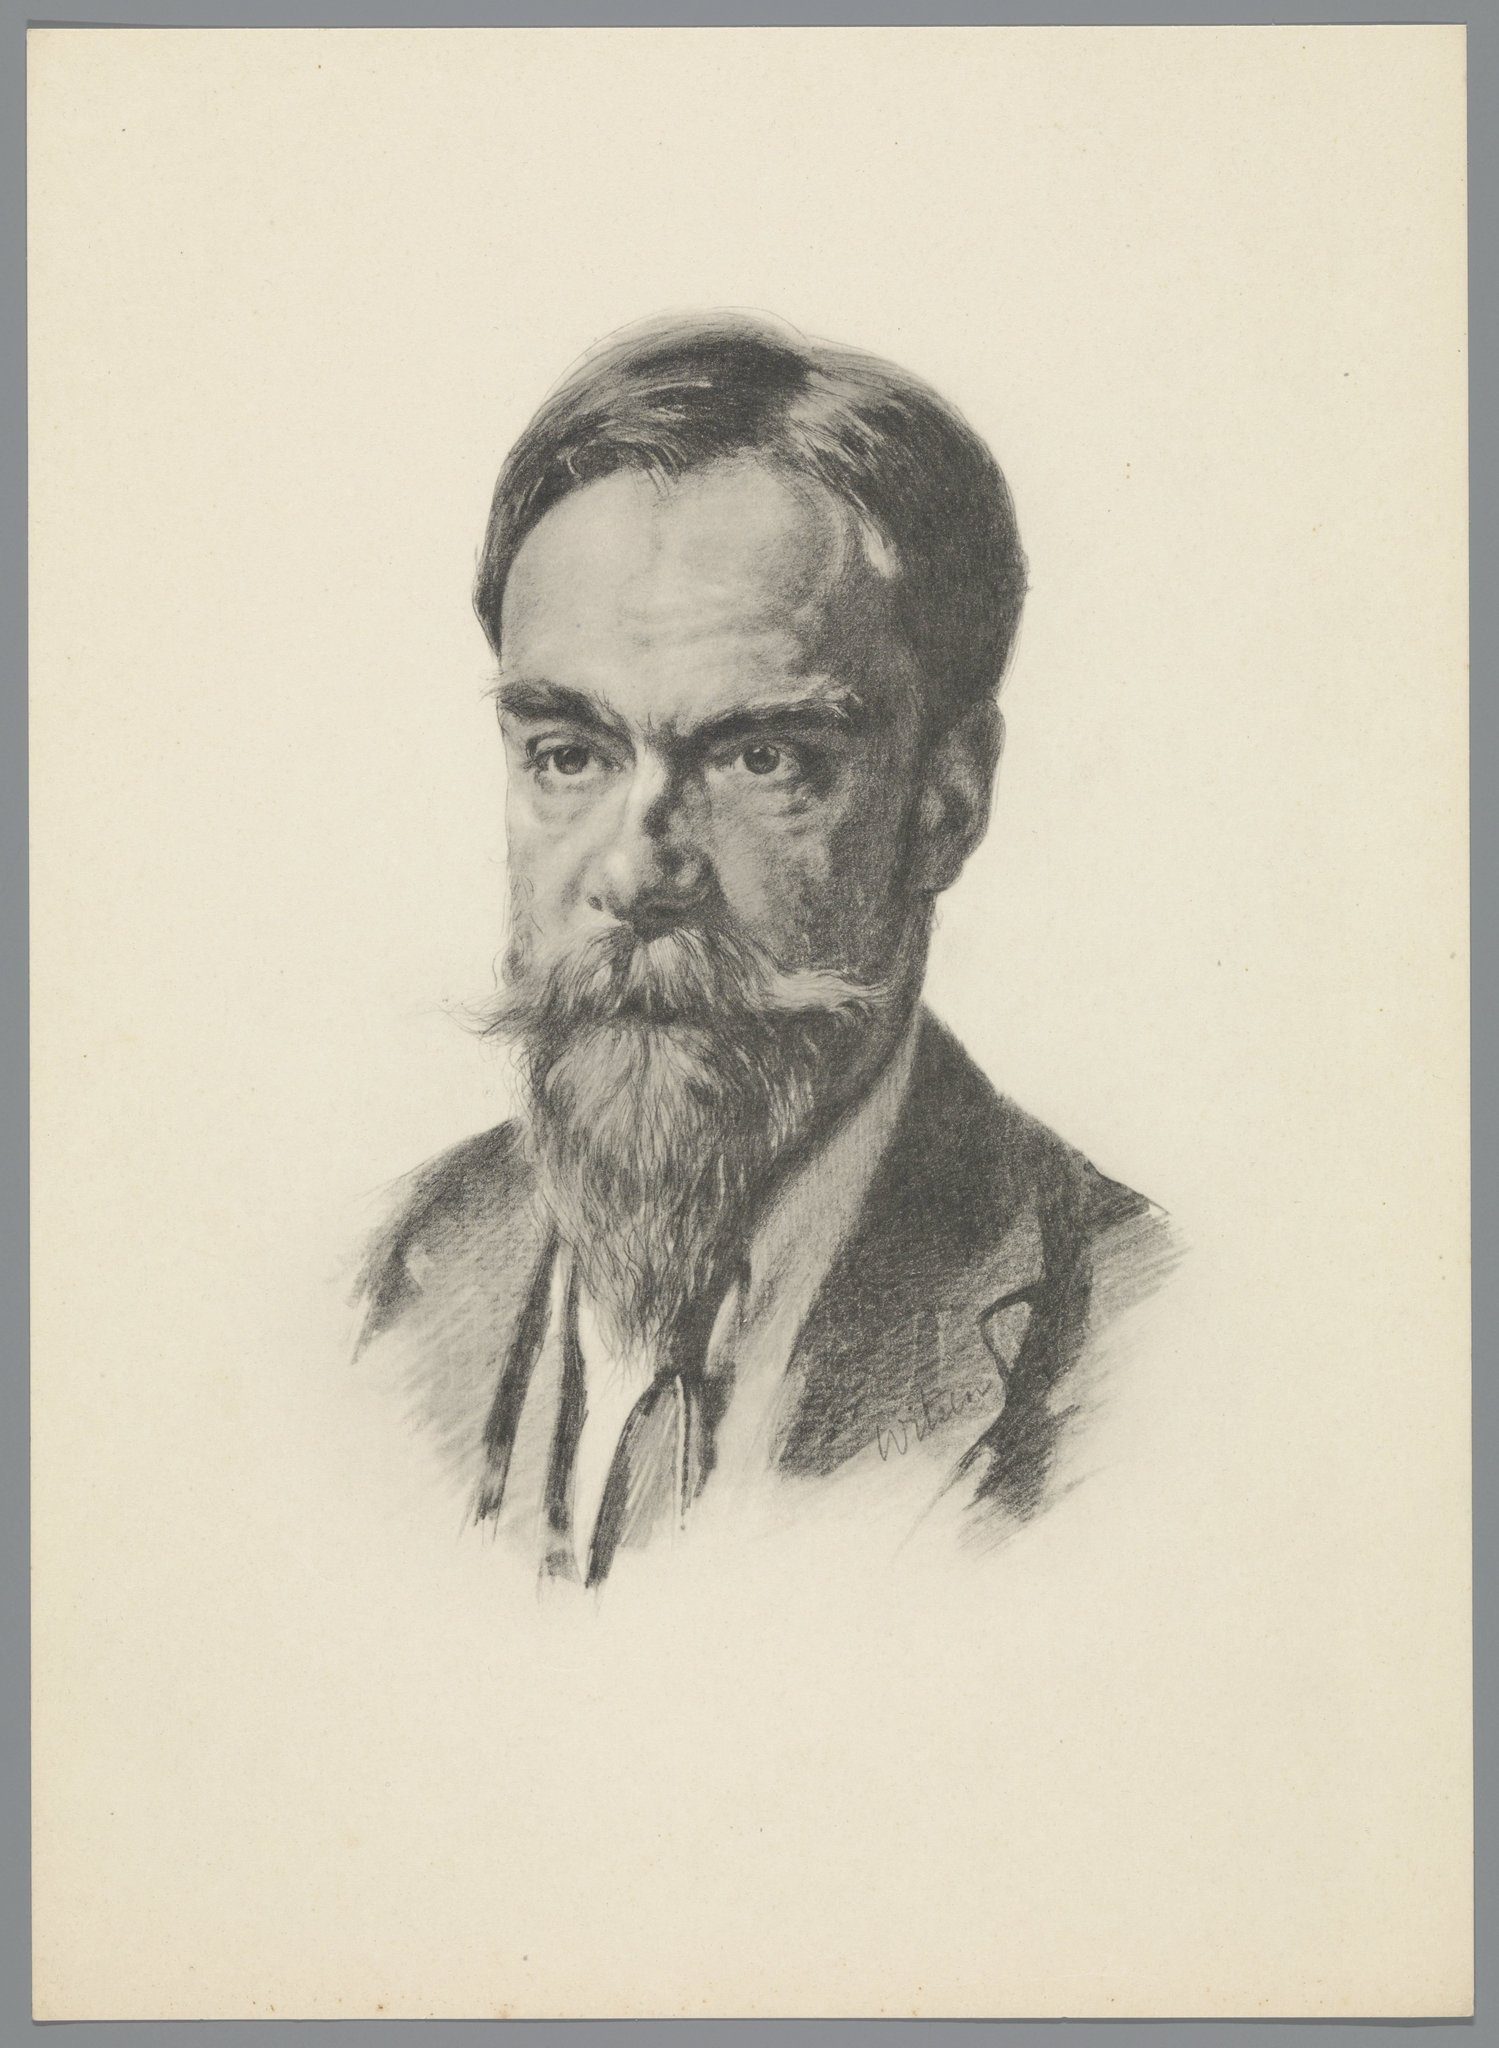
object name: print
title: Reproductie naar krijttekening met portret van Frans Coenen Jr.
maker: Anonymous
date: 1860-1915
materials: paper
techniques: photograph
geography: netherlands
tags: amsterdam, frans coenen (1866-1936)